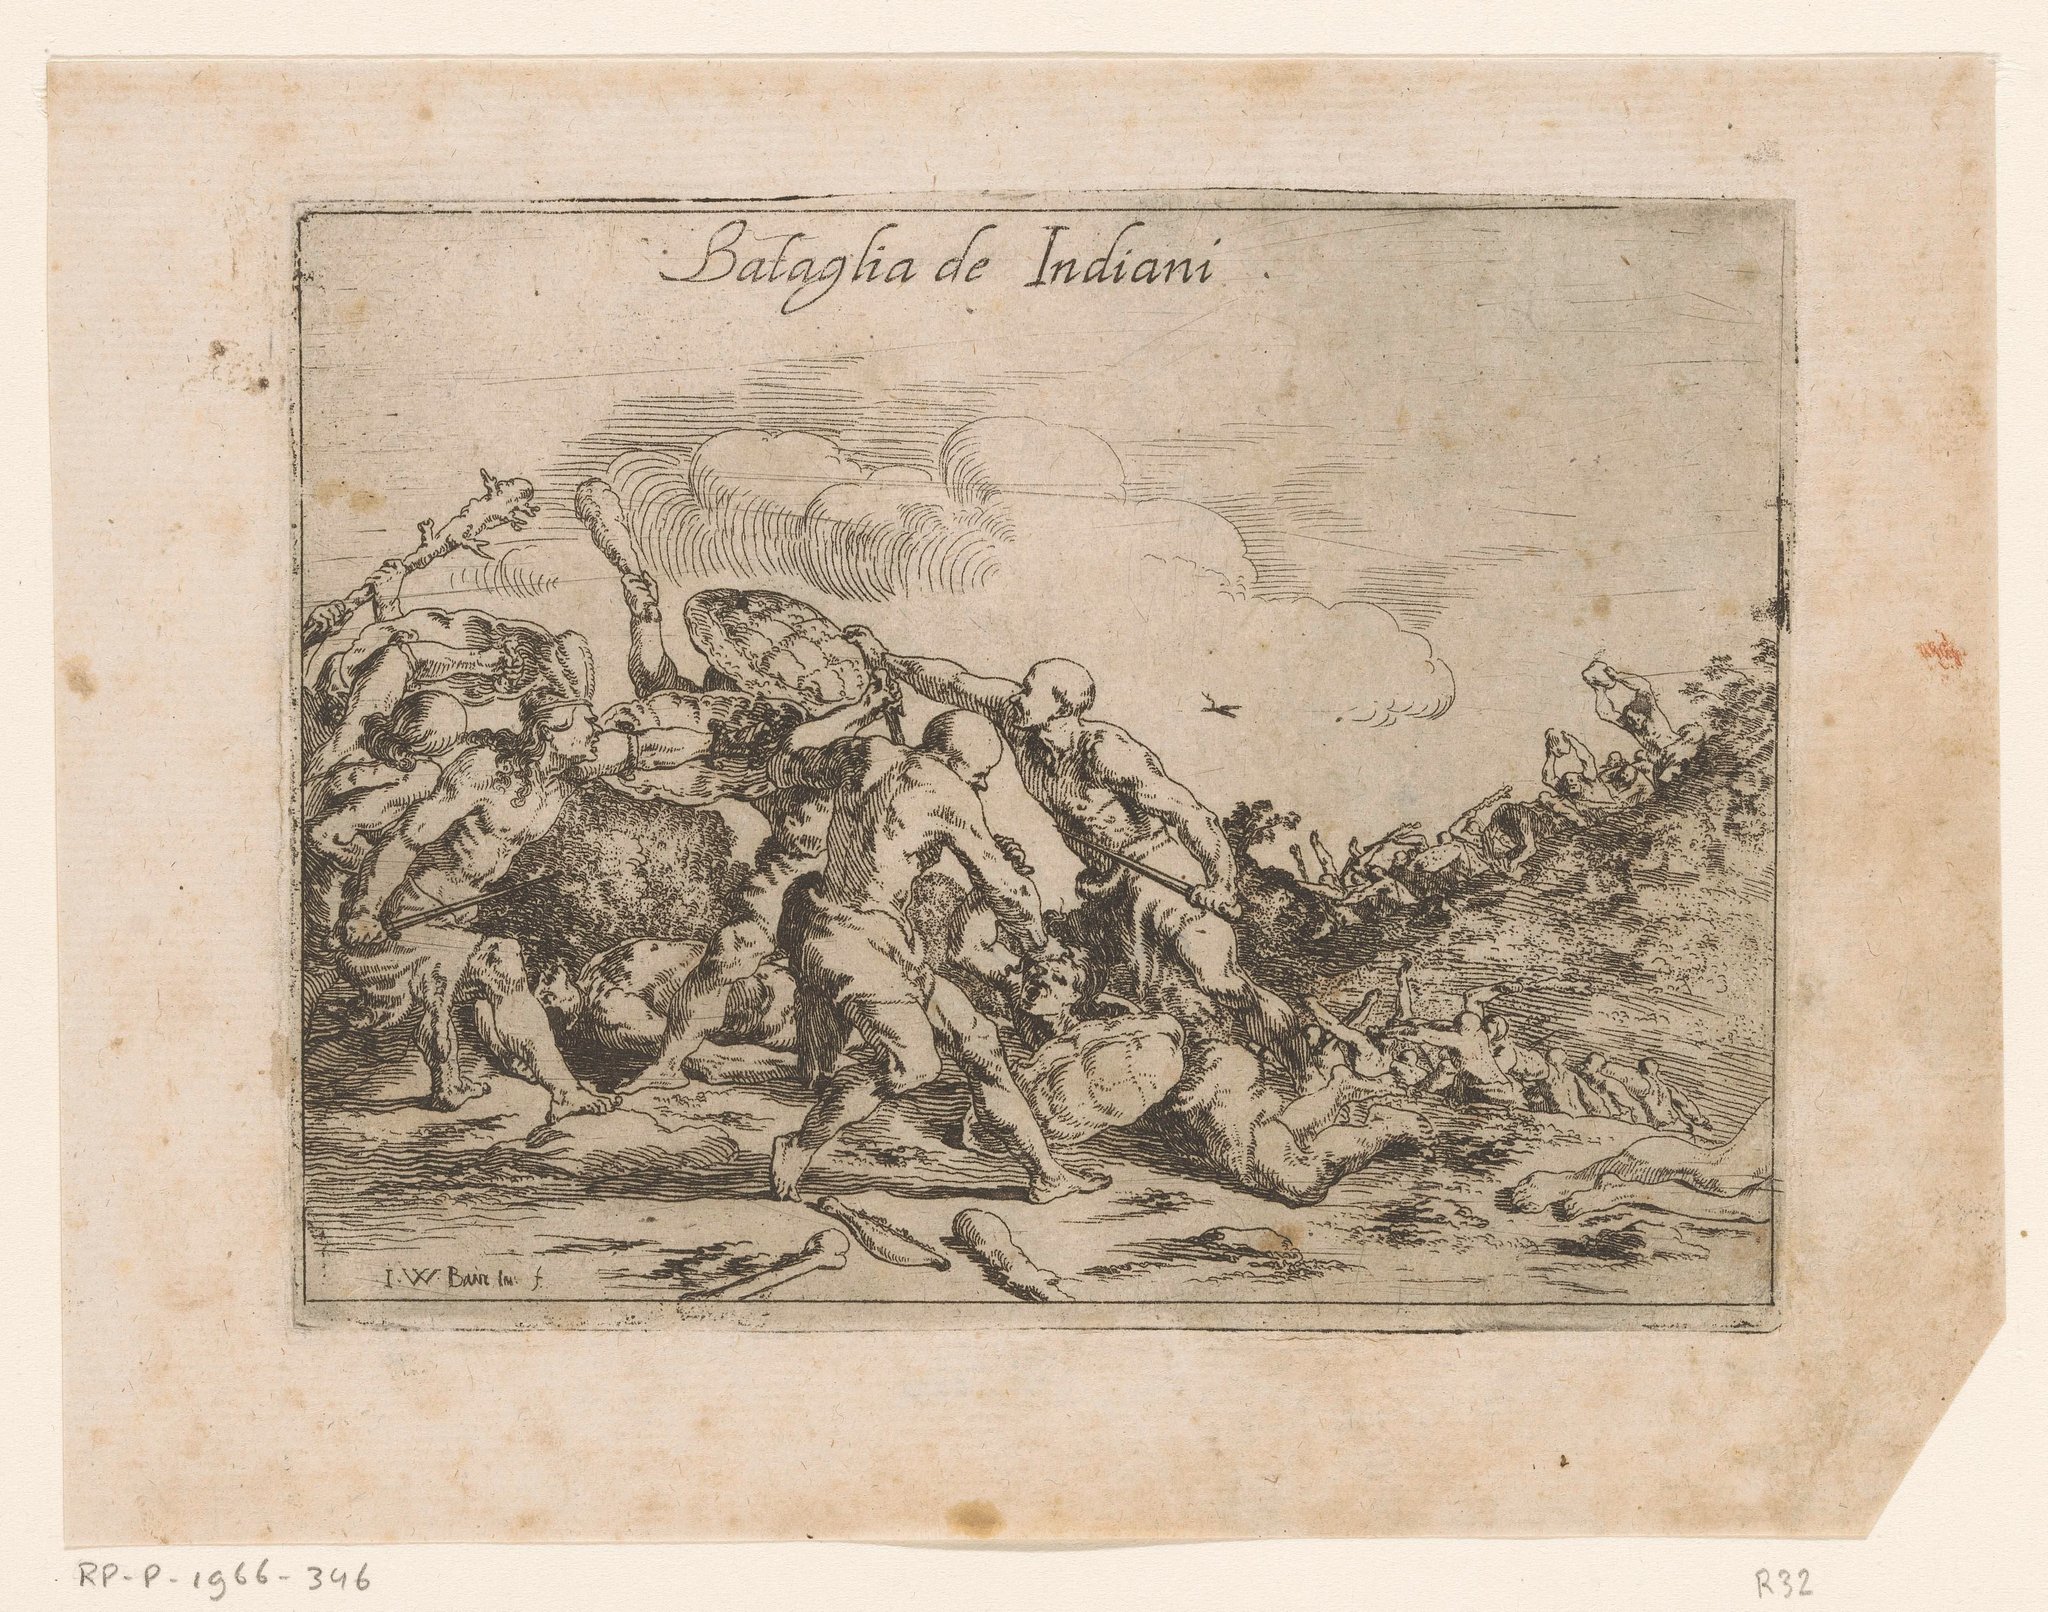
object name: print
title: Inwoners van Zuid-Amerika in een veldslag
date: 1633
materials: paper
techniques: etching, intaglio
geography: italy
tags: battle (+ infantry), indigenous peoples of south america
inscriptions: collector's mark: Lugt 5k, collector's mark: Lugt 2228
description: Negende prent uit de serie 'Veldslagen door verschillende volkeren', bestaand uit een titelprent en dertien prenten.